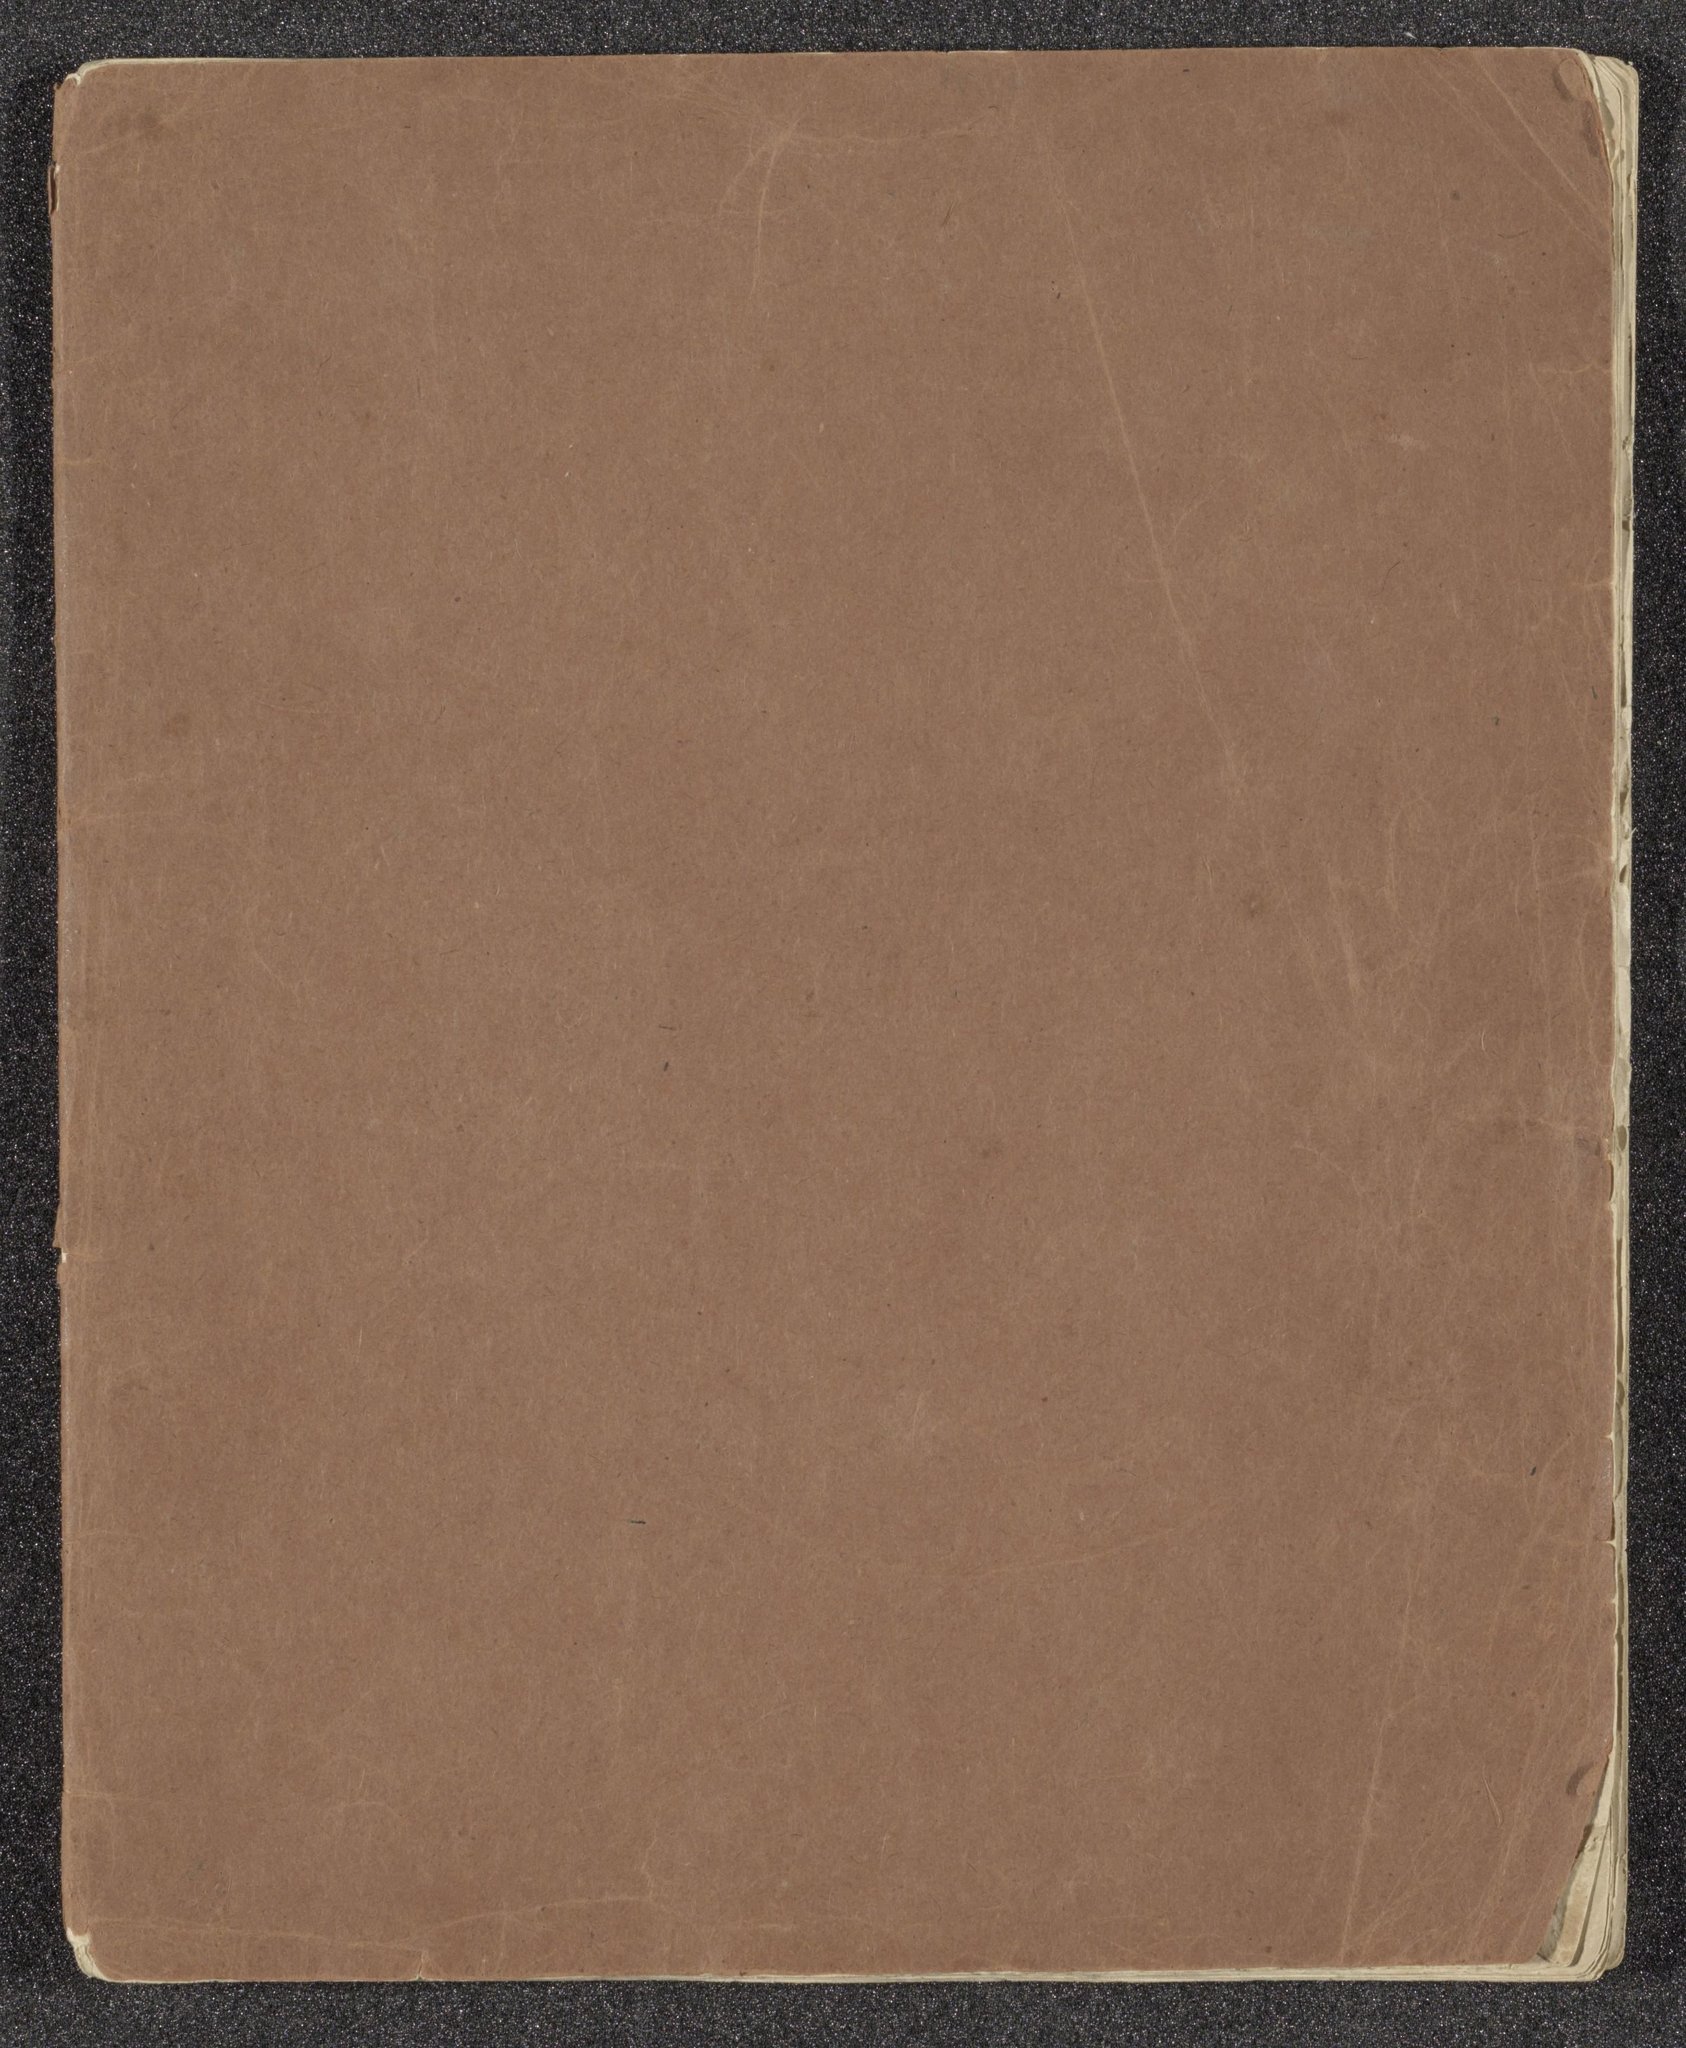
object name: exercise book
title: Album met 8 foto's van (vermoedelijk) een Franse familie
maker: Anonymous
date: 1900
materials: paper, photographic support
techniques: collodion silver print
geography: france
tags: historical persons, family, relationship, descent, france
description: Fotoalbum in een schrift met een bruine kaft. Het binnenwerk bestaat uit 14 bladzijden met 8 foto's. Het zijn portretten en groepsportretten van een (vermoedelijk) Franse familie, gemaakt in een landelijke omgeving rond 1900.